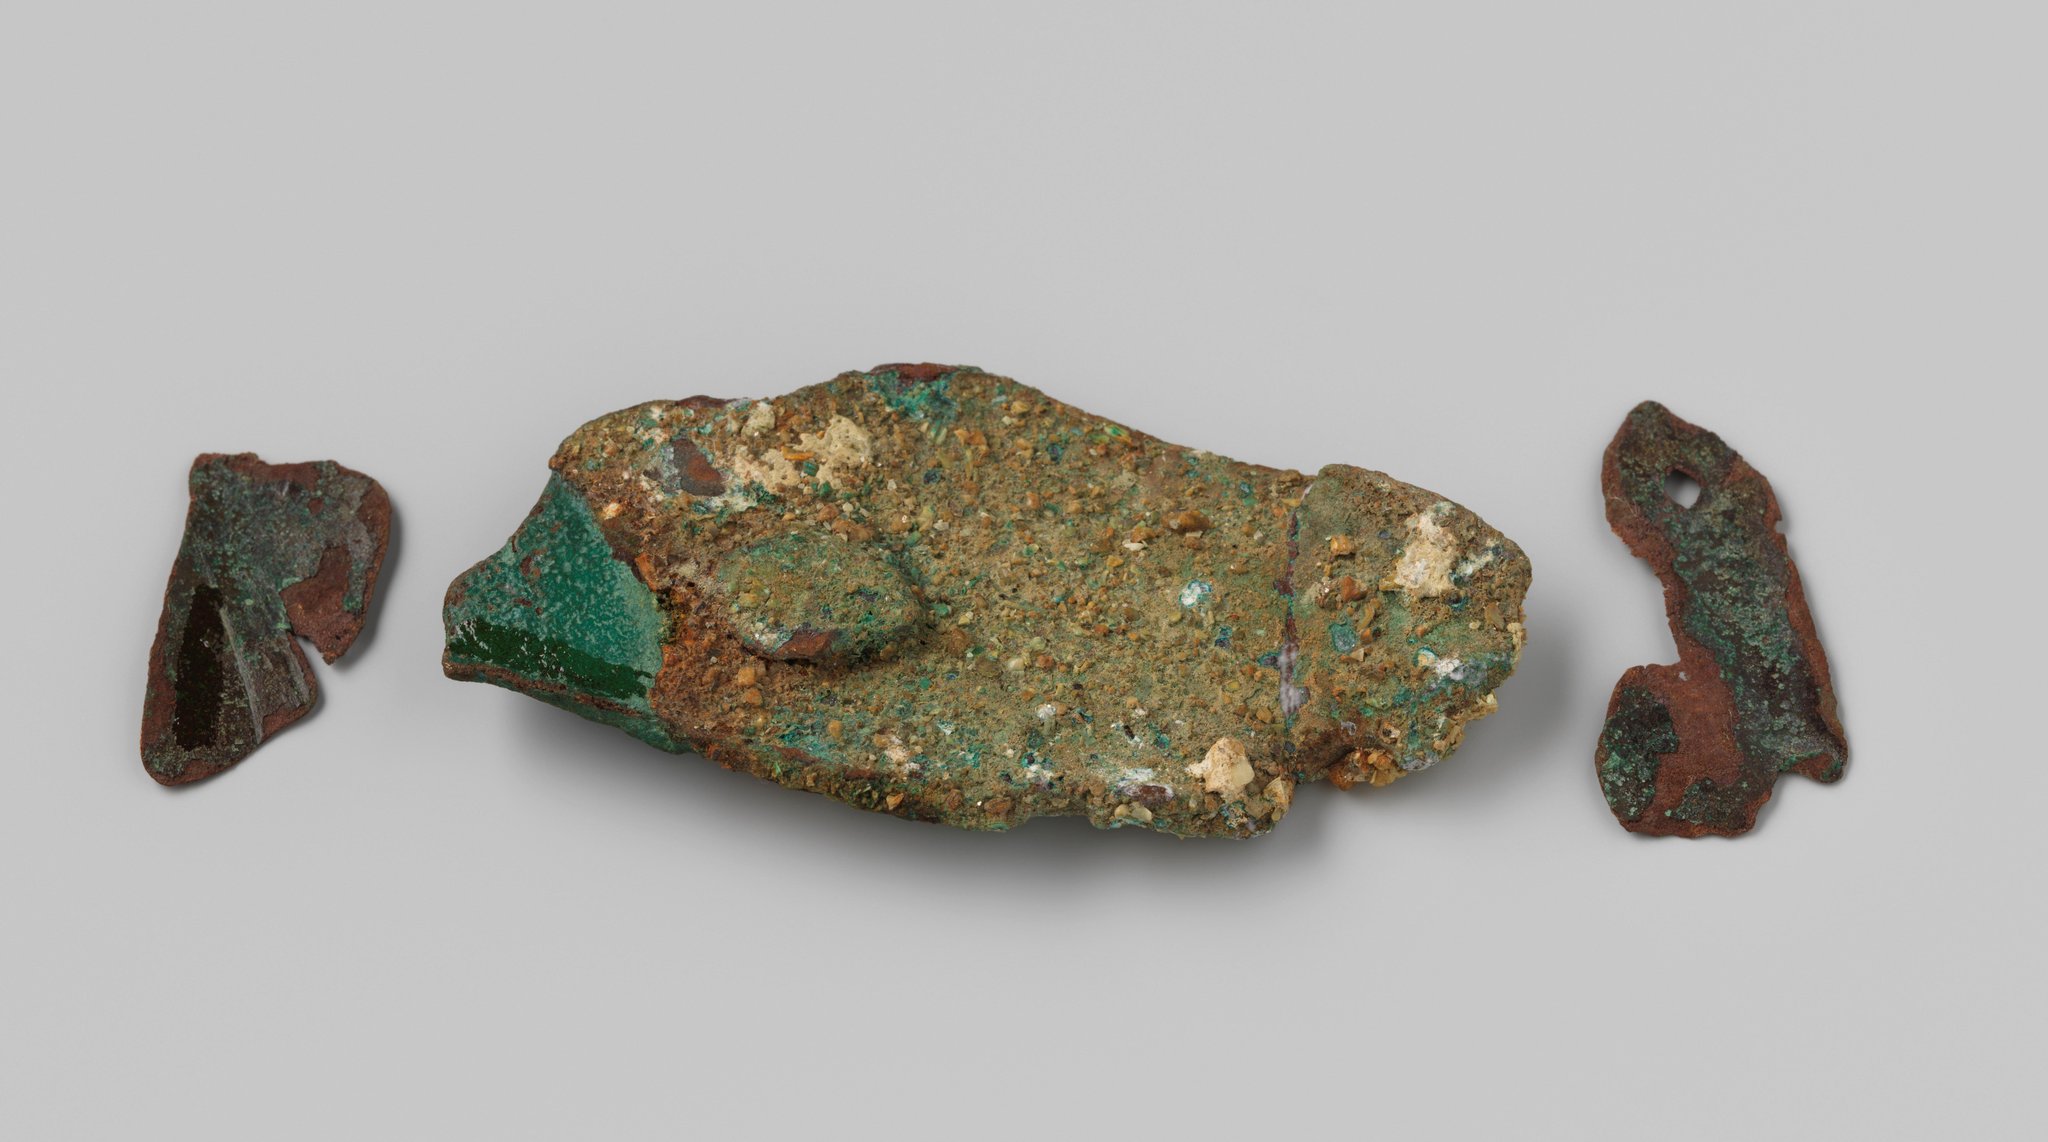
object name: fragment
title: Fragmenten koper uit het wrak van de Oost-Indiëvaarder Hollandia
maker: Anonymous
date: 1700-1743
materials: copper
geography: netherlands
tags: verenigde oostindische compagnie, hollandia (schip), annet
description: Varied parts or fragments, sheet metal fragments: worked, with rivets; fragm, eroded, 1 rivet.